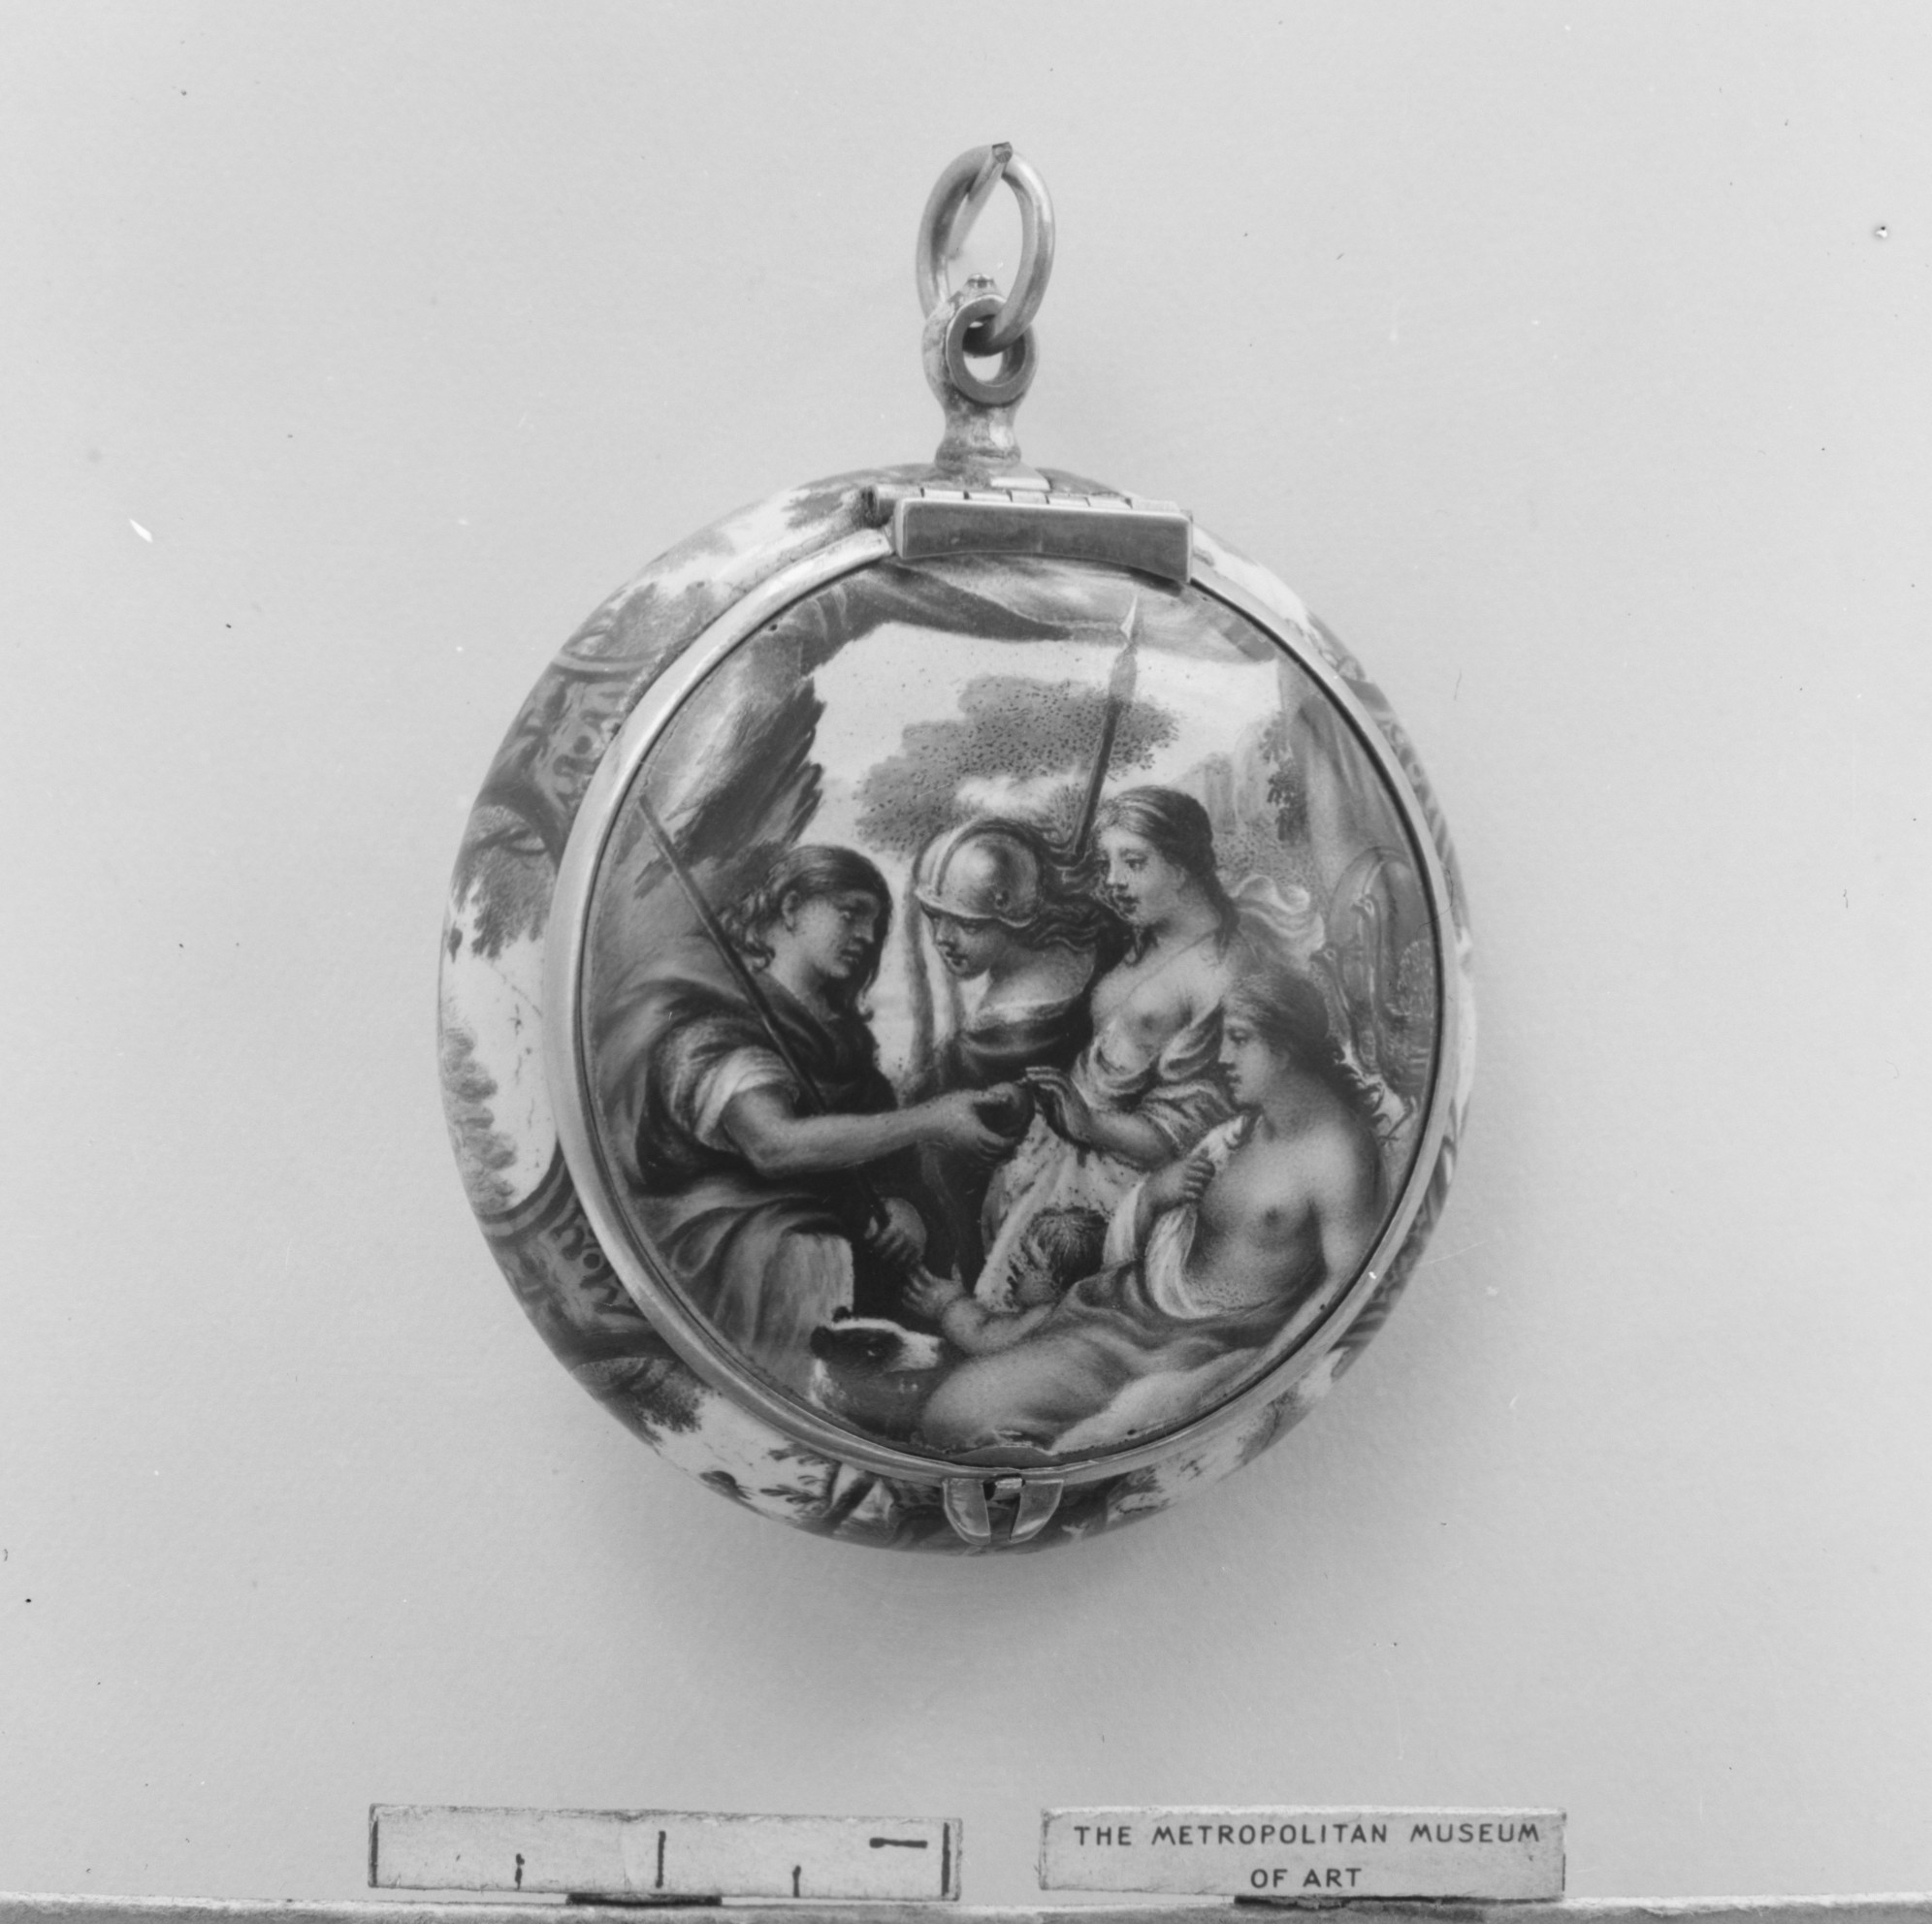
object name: watch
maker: pierre duet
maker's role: maker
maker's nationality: french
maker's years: 1700-1760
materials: enamel, metal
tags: children,men,women,dogs